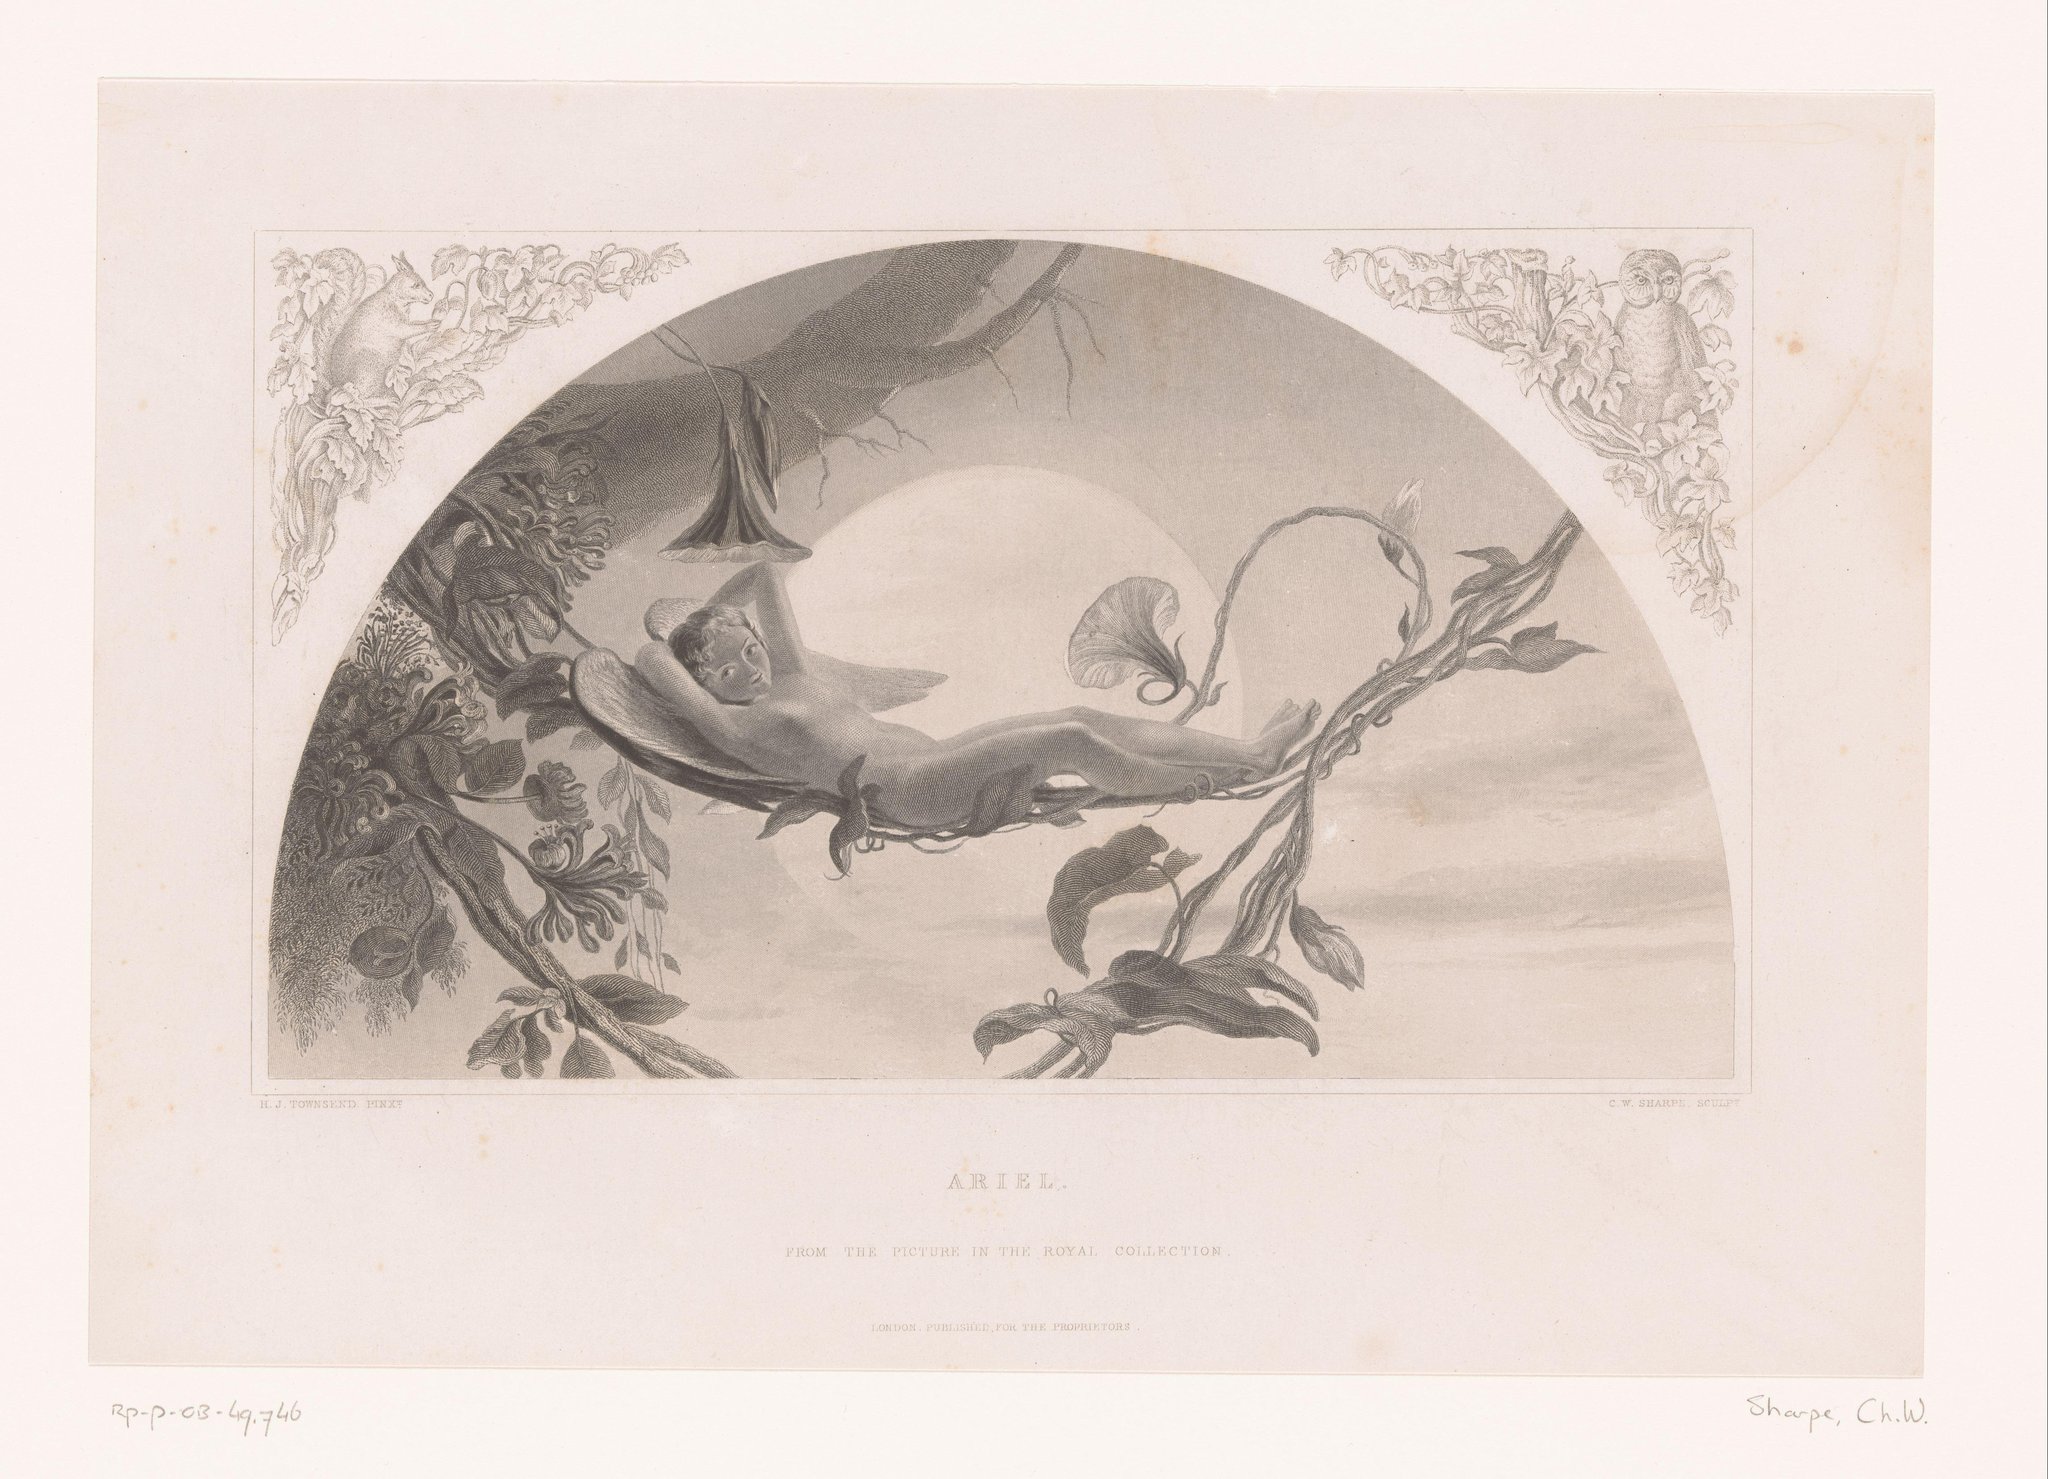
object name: print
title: Ariel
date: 1845-1920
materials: paper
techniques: engraving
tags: fairy - aa - female human figure, (scenes from) specific works of literature: shakespeare, tempest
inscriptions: collector's mark: Lugt 2228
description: De luchtgeest genaamd Ariel uit William Shakespeares toneelstuk 'The Tempest'. Gevleugeld vrouwelijk figuur liggend in een hangmat van winderanken en kamperfoelie.